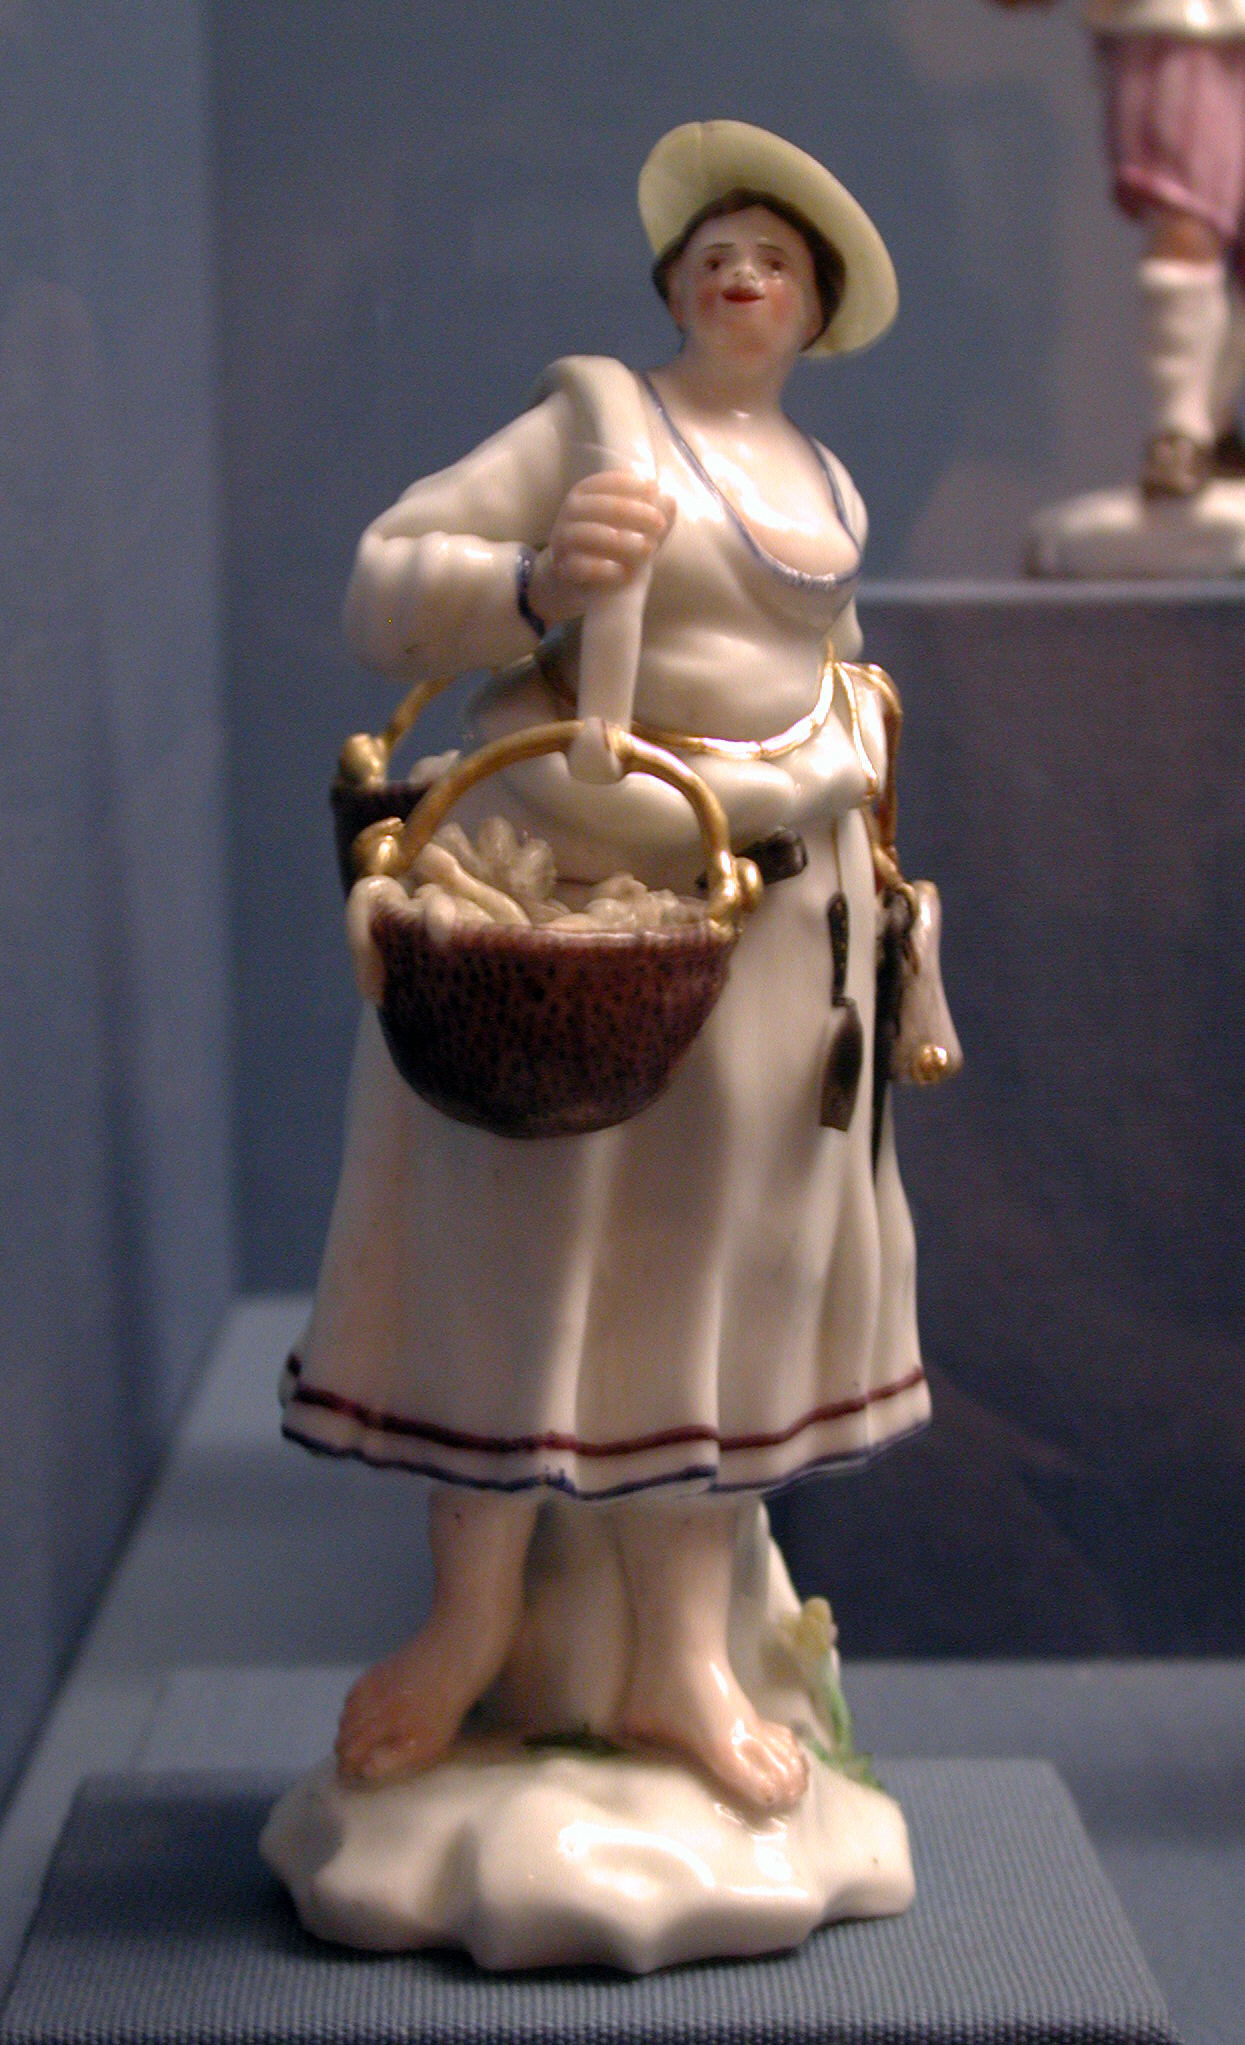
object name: figure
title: Peddler of eels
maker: capodimonte porcelain manufactory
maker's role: manufactory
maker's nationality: italian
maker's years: 1740-1759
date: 1750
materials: soft paste porcelain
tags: women